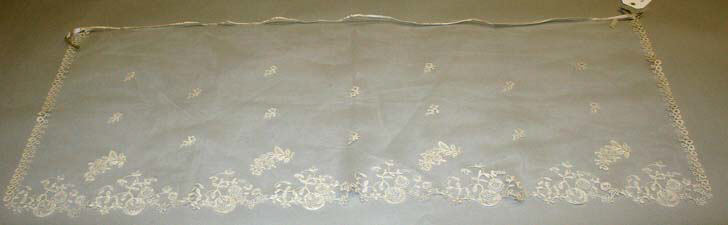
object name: veil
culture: british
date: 1801-1900